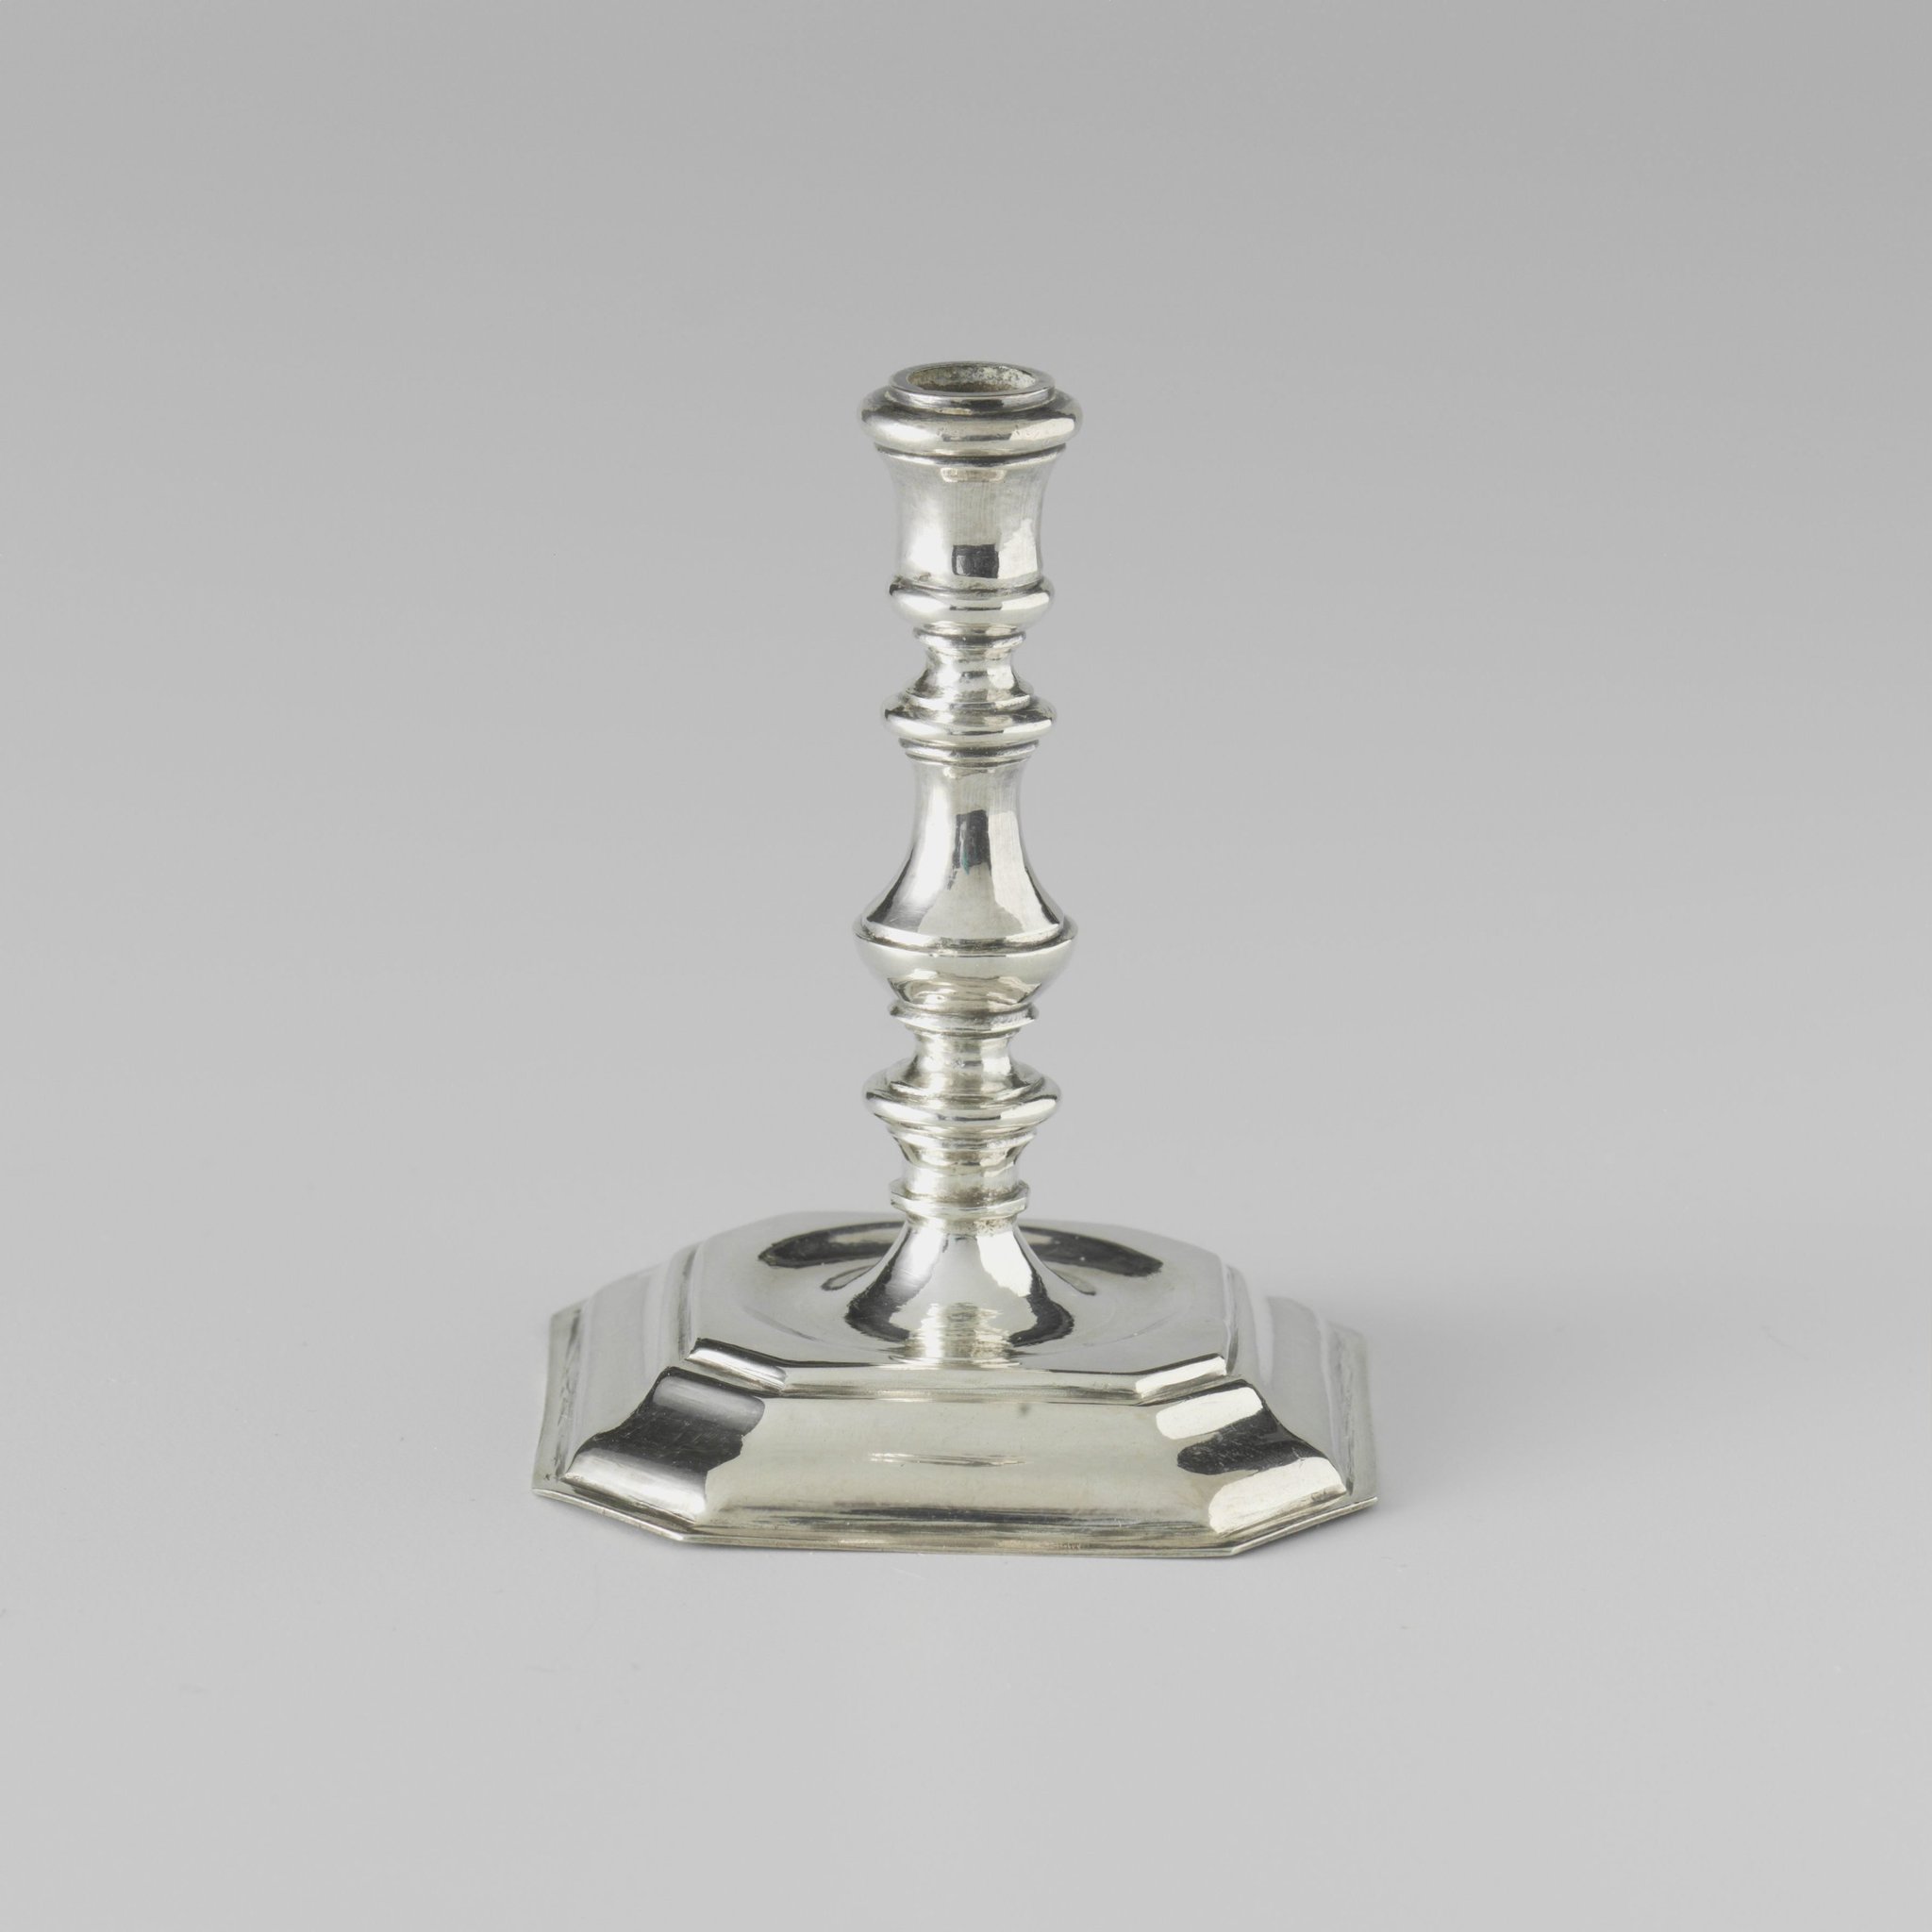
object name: miniature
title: Kandelaar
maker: willem van strant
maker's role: silversmith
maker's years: 1682-1742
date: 1739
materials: silver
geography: amsterdam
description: Kandelaar op een vierkante, geprofileerde, gewelfde voet met afgeschuide hoeken. De stam is geprofileerd en balustervormig. De kandelaar is gemerkt: stk.= Amsterdam, jrl.= E (1739), mt.= Willem van Strant en een bijltje. De kandelaar is gelijk aan de kandelaar met het invnr. BK-15108-a.